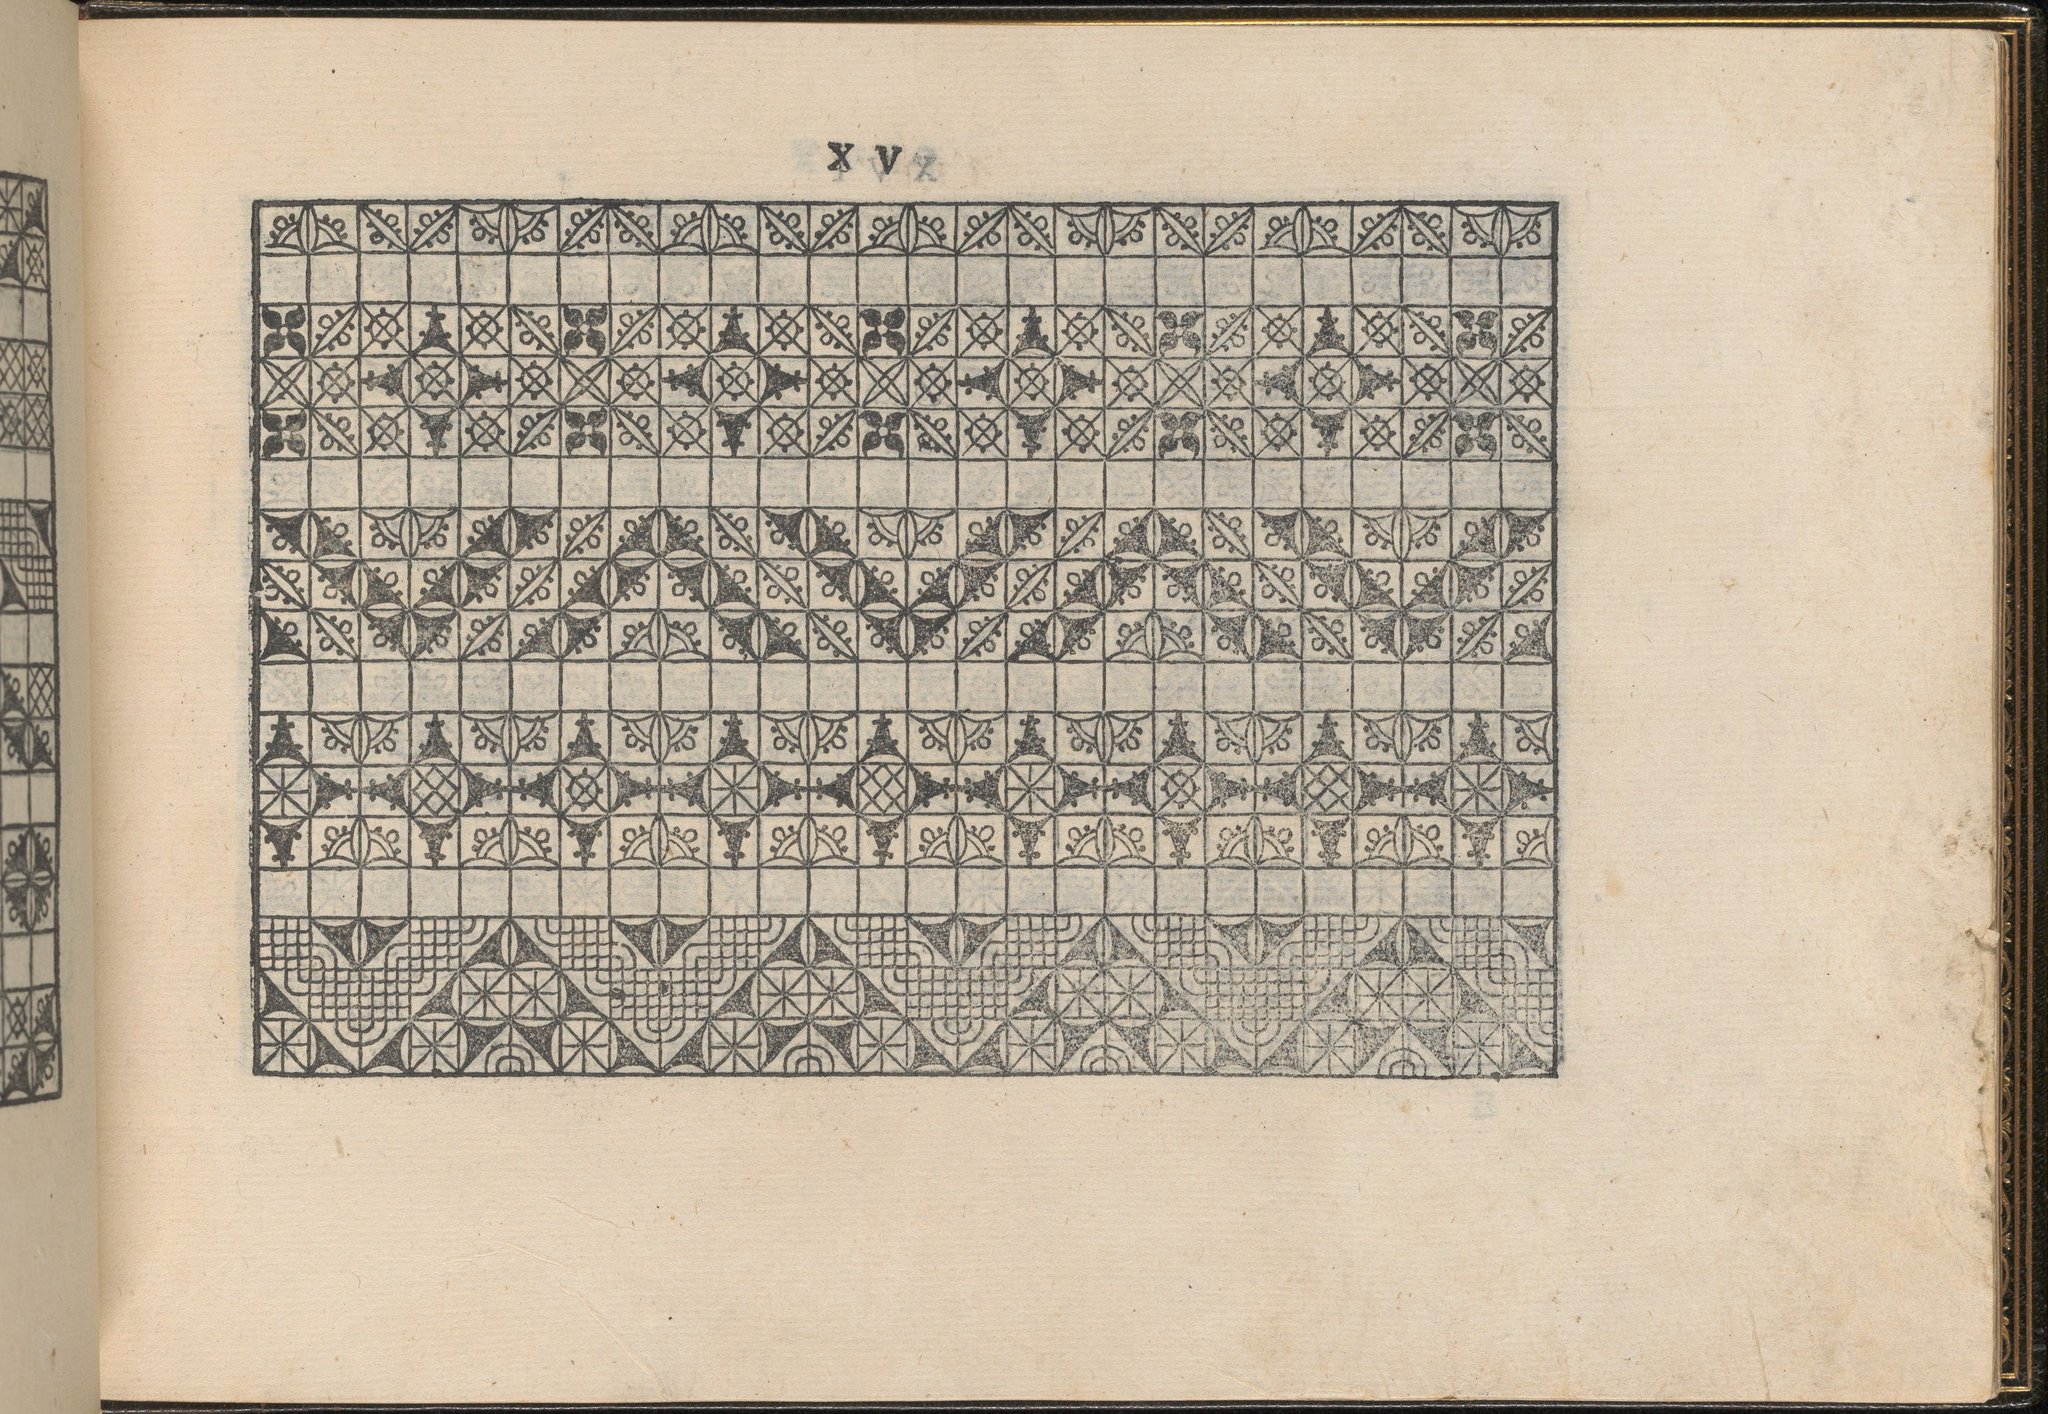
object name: book print ornament architecture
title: La Vera Perfettione del Disegno di varie sorti di recami, page 8 (recto)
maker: giovanni ostaus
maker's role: publisher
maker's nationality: italian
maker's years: 1507-1607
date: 1567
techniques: woodcut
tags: ornament